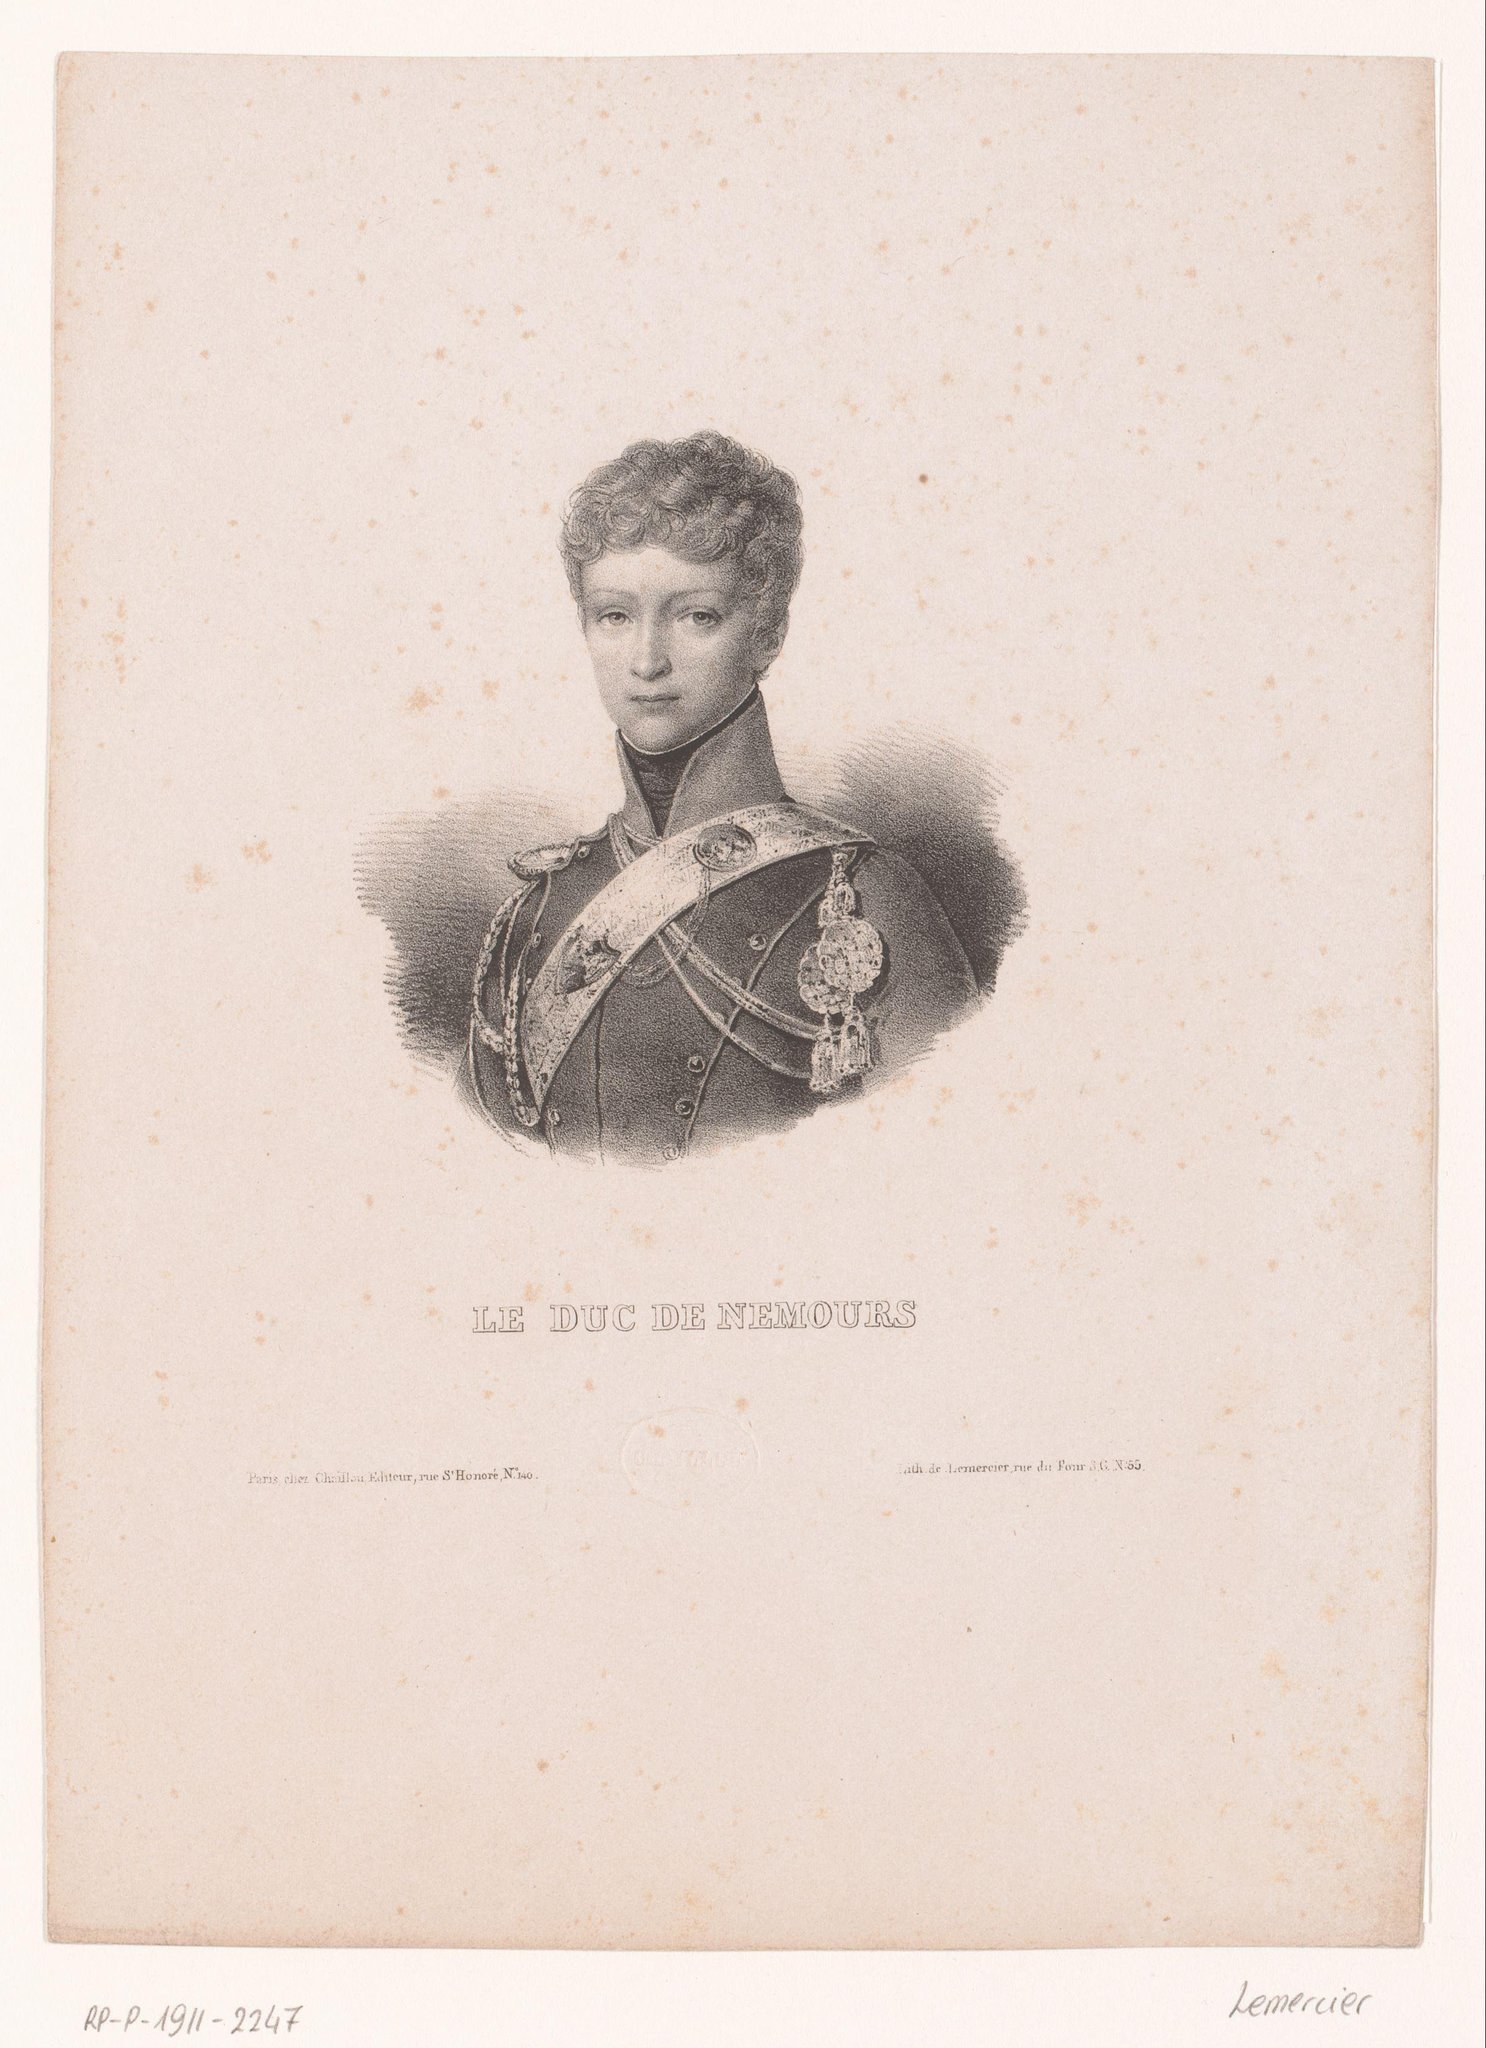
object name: print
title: Le Duc de Nemours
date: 1833-1837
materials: paper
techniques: lithograph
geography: paris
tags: paris, historical persons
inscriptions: check stamp: Lugt 4733, collector's mark: Lugt 2228a